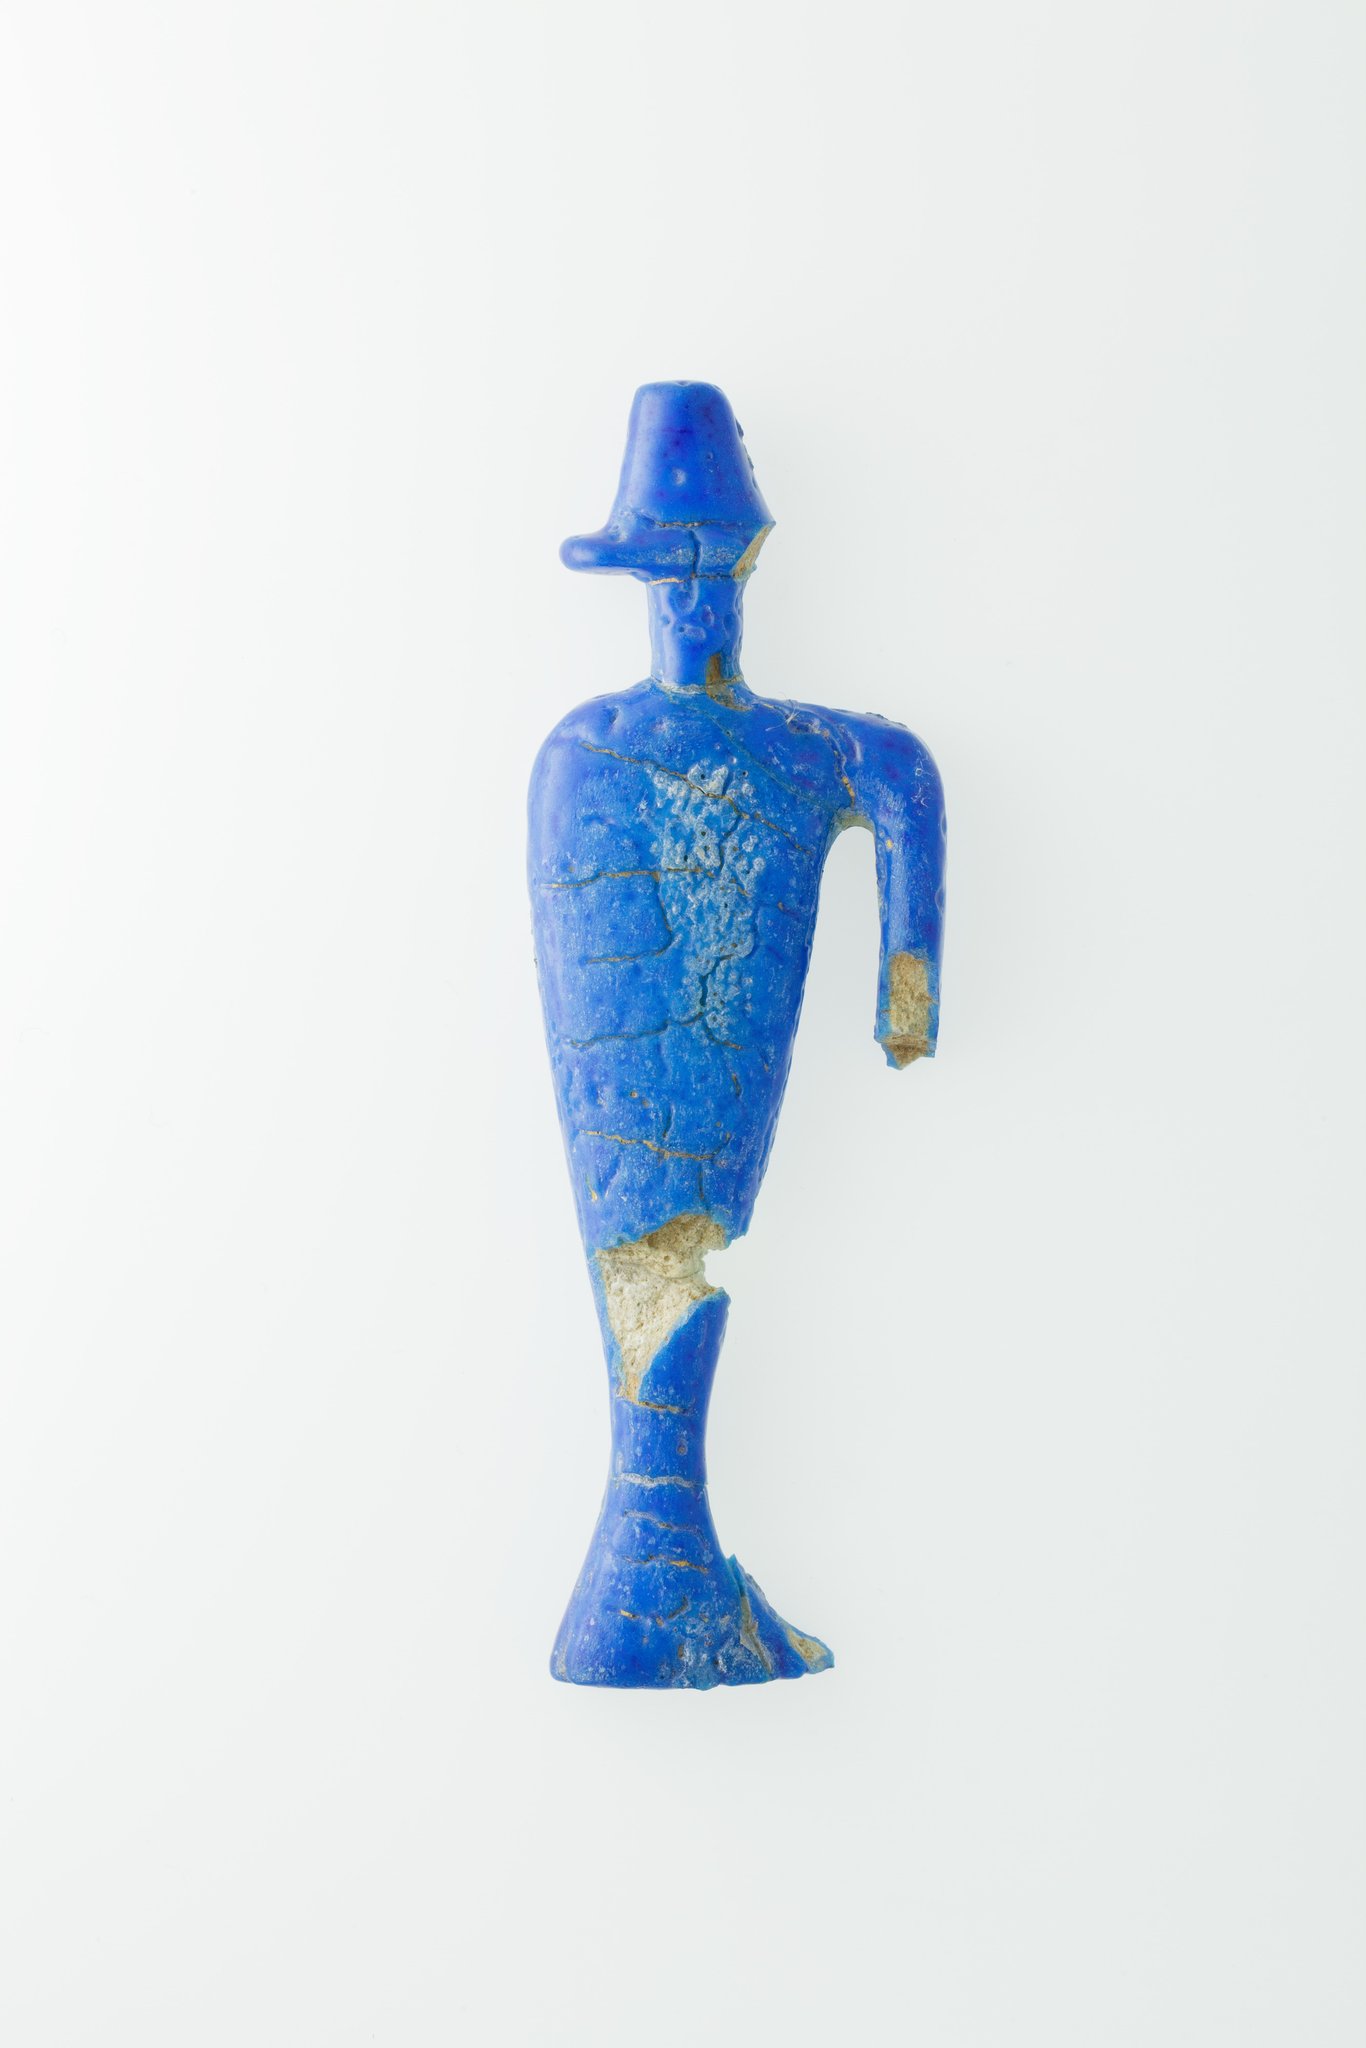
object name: inlay, hieroglyph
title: Inlay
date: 664-610 BCE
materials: faience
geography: egypt